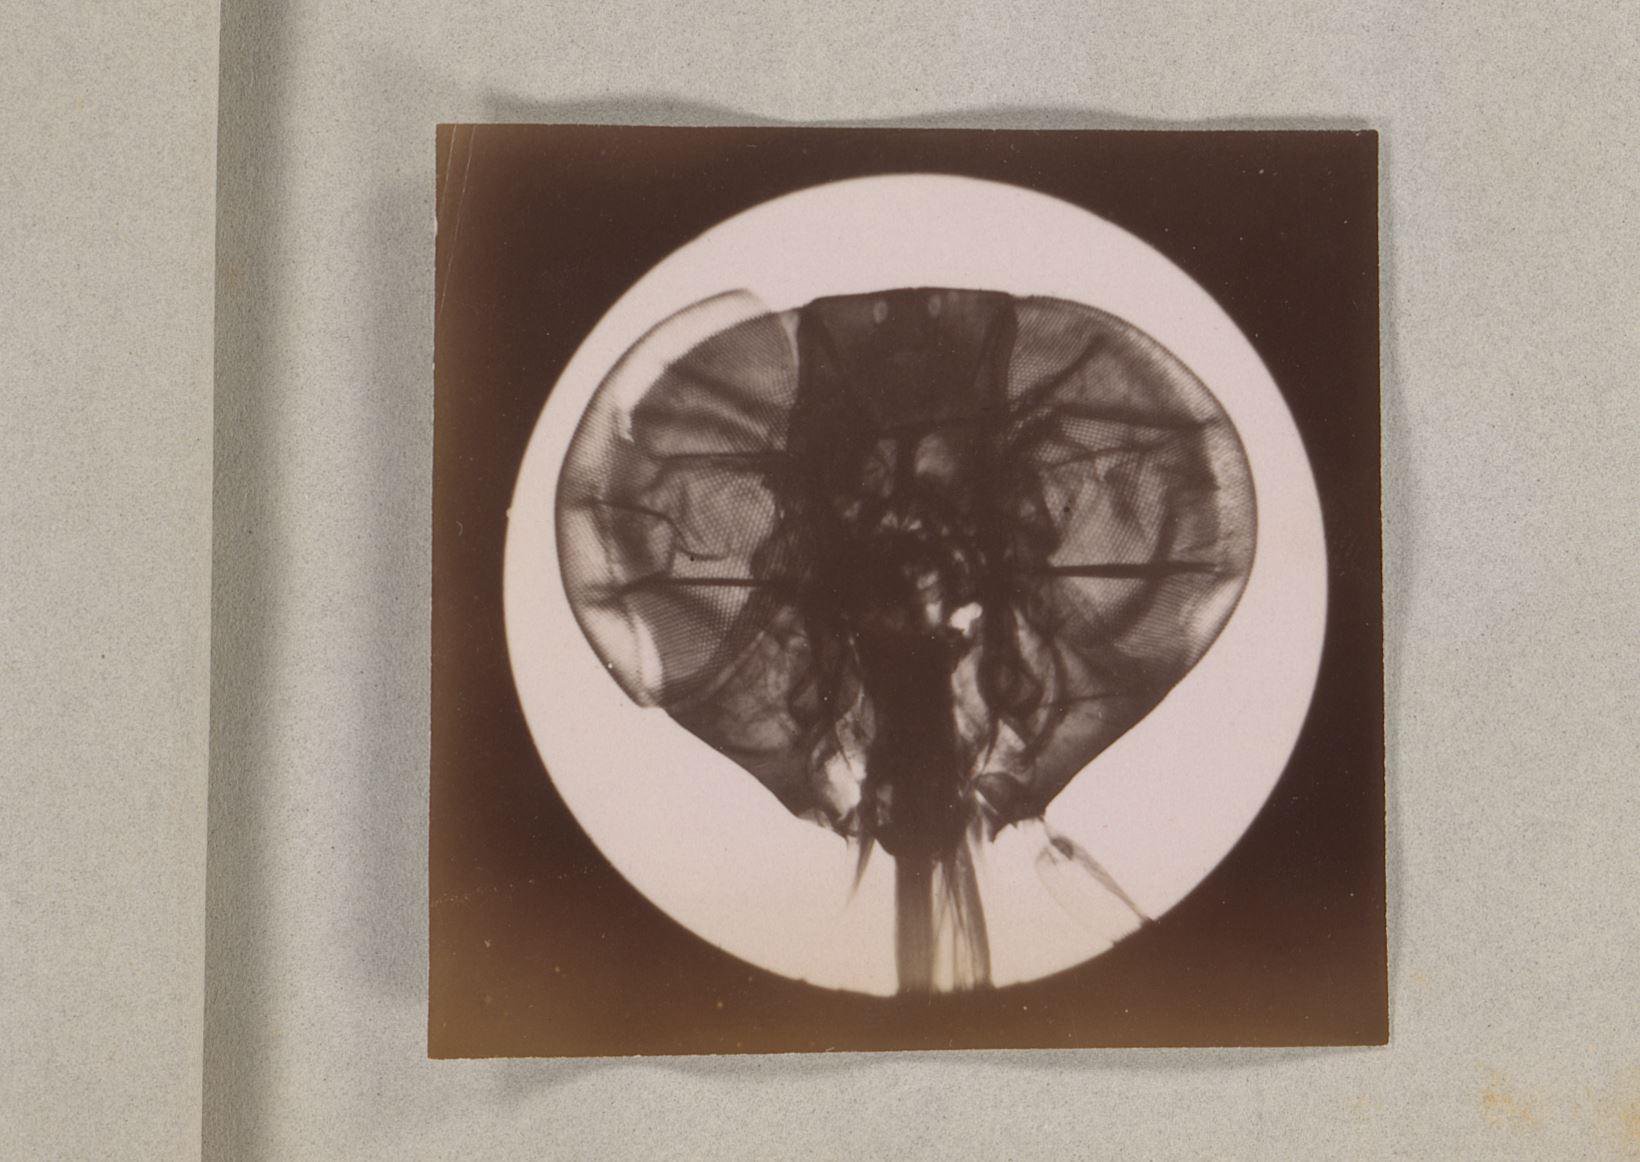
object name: photograph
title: Microscopische opname van kop van een vlieg, 25 keer vergroot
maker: marinus pieter filbri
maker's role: instrument maker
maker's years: 1852-1917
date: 1887-1888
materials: paper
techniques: albumen print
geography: netherlands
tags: insects: fly, netherlands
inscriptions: inscription: ‘Studie voor pose bij een wetenschappelijk/ onderwerp’